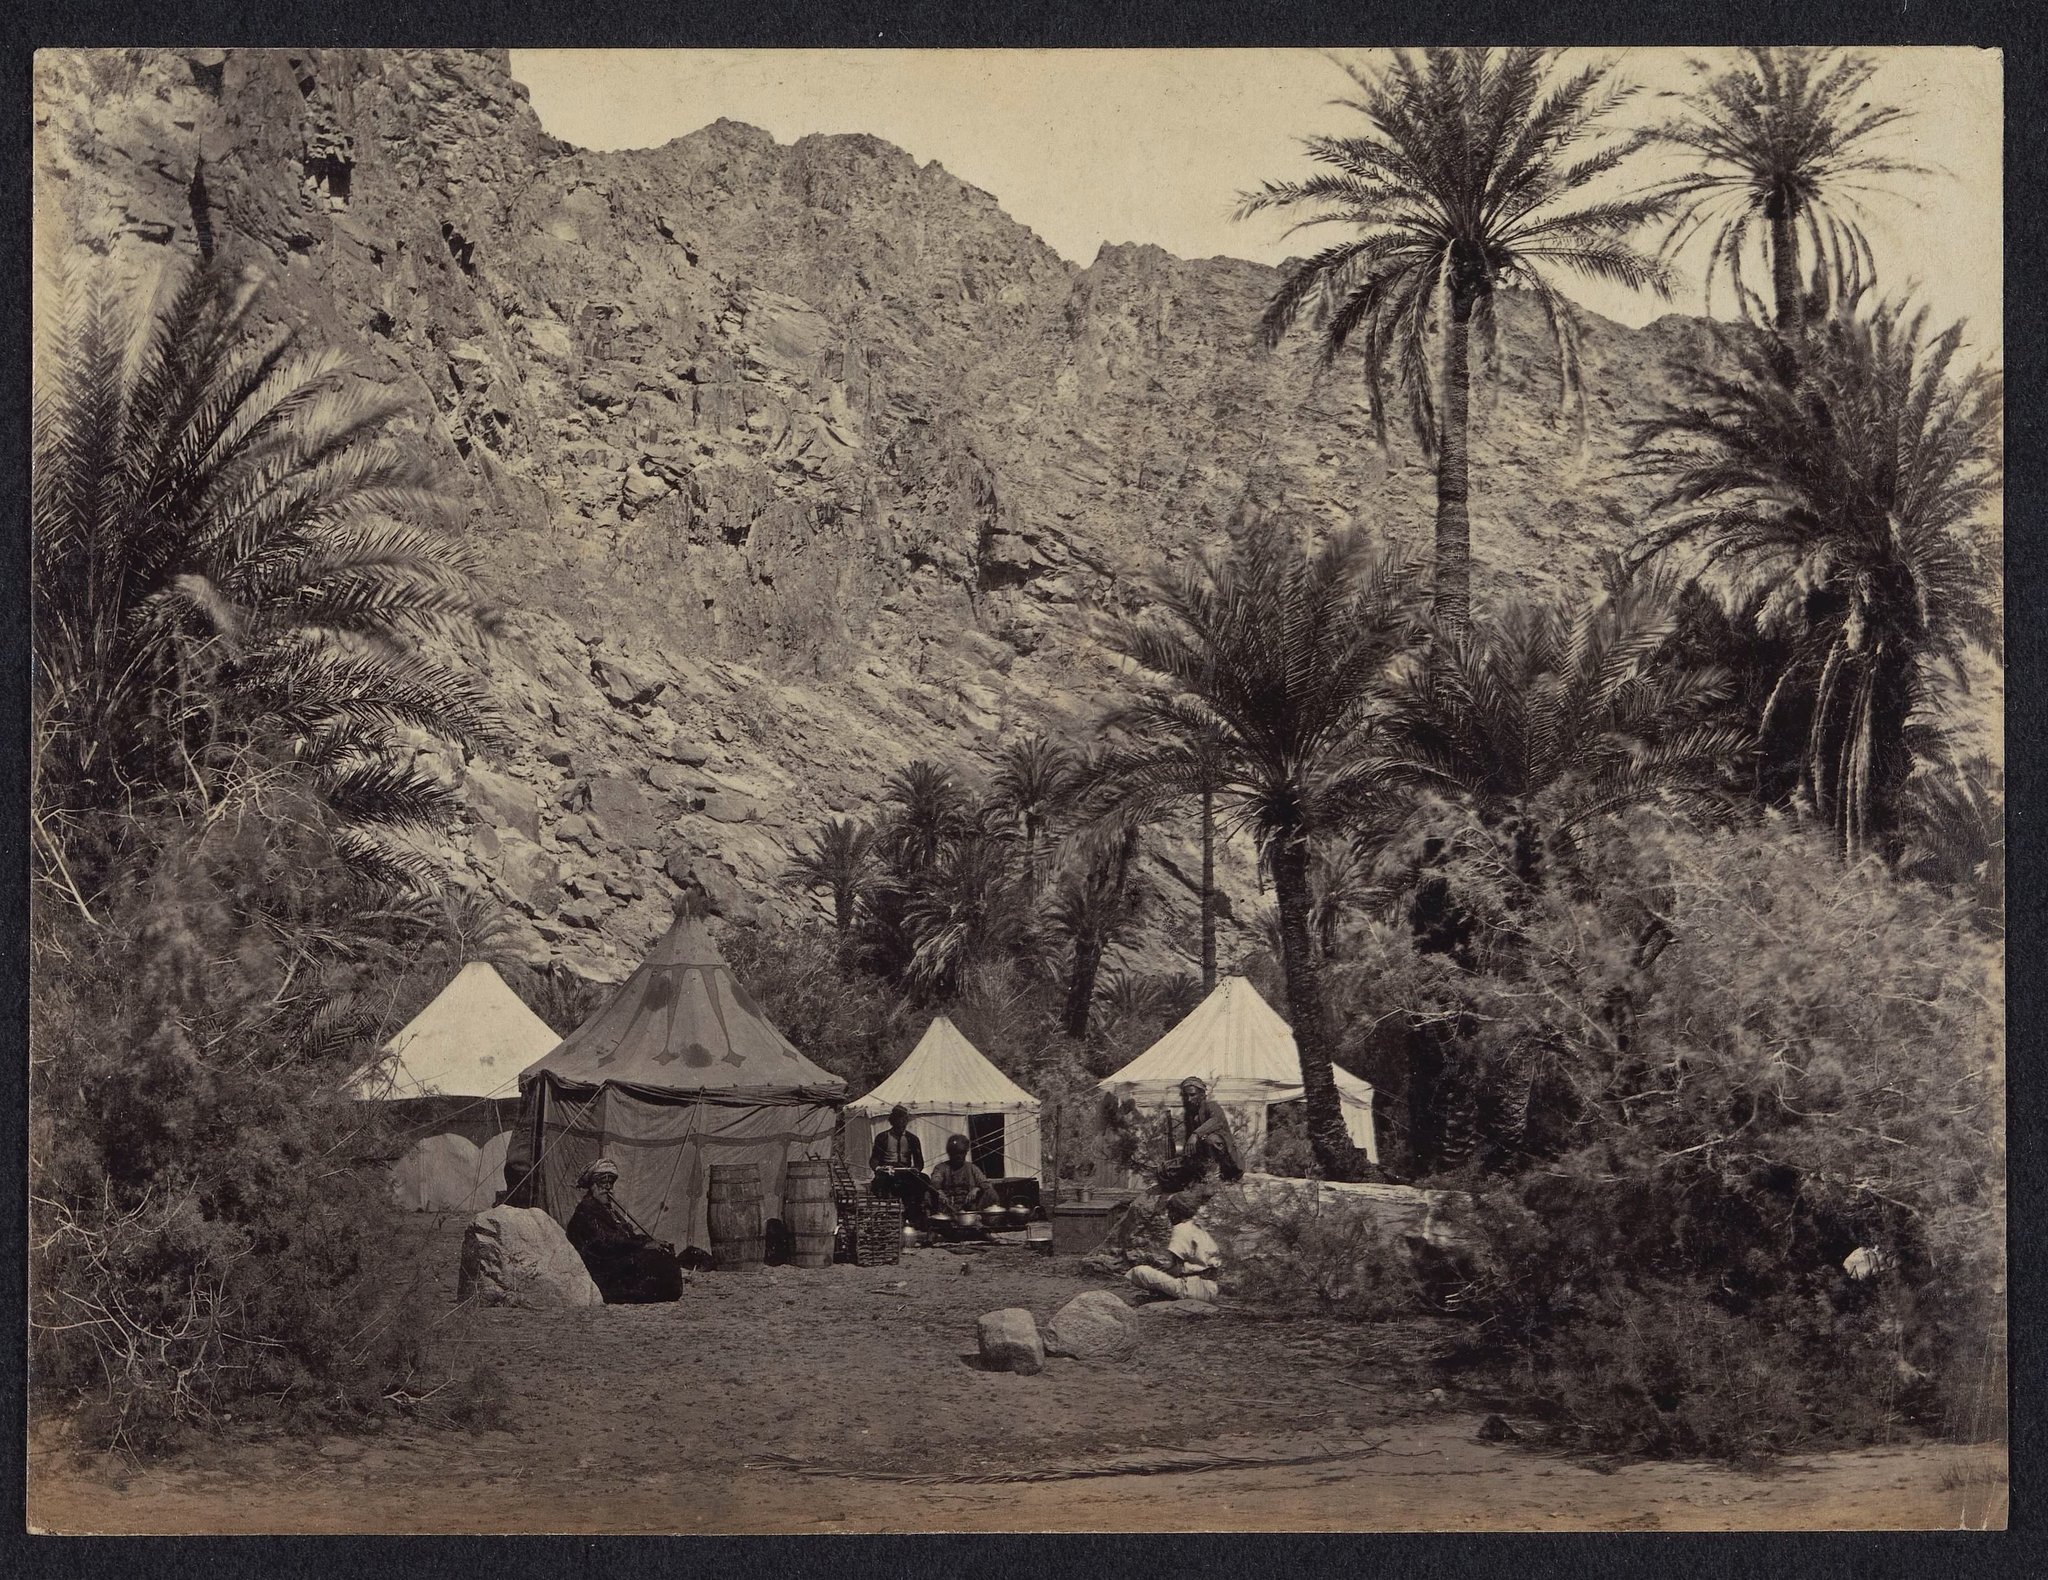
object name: photograph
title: A tent camp in a mountain landscape, Sinai, Egypt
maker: Anonymous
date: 1860-1890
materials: paper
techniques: albumen print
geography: sinai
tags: tent-camp, mountains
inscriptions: inscription: ‘4/ Encampment Wilderness of Paran/ 529’